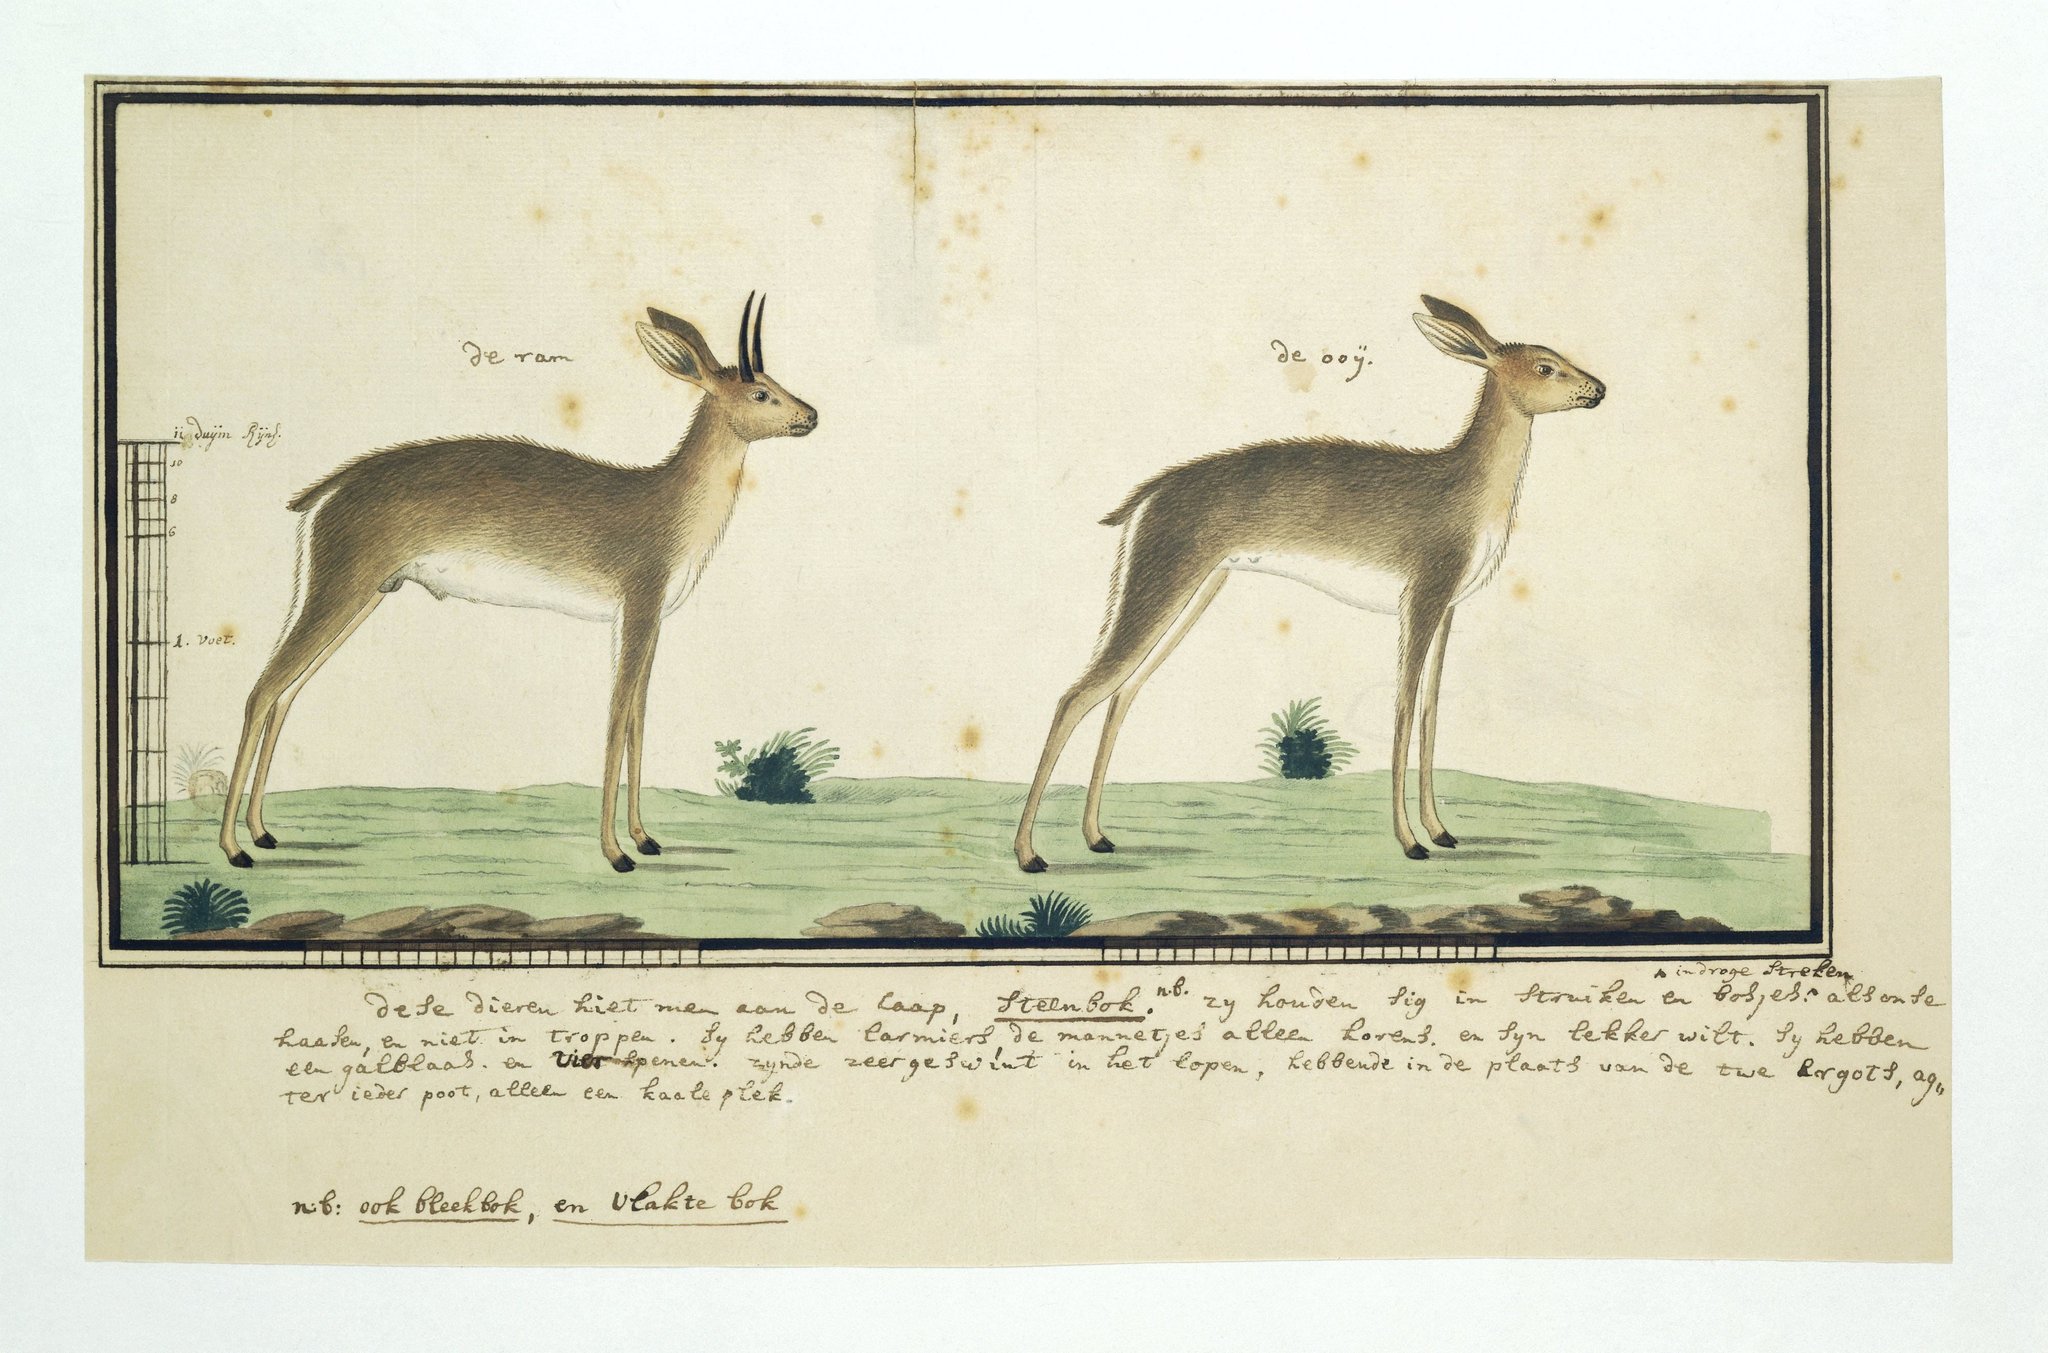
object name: album leaf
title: Raphicerus campestris (Steenbok)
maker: robert jacob gordon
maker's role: draughtsman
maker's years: 1743-1795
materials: paint, ink, paper, pencil, watercolor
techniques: brush, pen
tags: hoofed animals: ibex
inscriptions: annotation: ‘'de ram'; en 'de ooij' [boven de bokken]; dese dieren hiet men aan de Caap, Steenbok [onderstreept] [...]; schaalverdeling met voet en duim Rijnl., in kaderlijnen onderaan ook een schaalindeling in duim [maar zonder tekst]’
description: Kaapse steenbok (Raphicerus campestris), ook genaamd bleekbok, vlaktebok of bok: ram en ooi; met schaalverdeling in Rijnlandse maat.